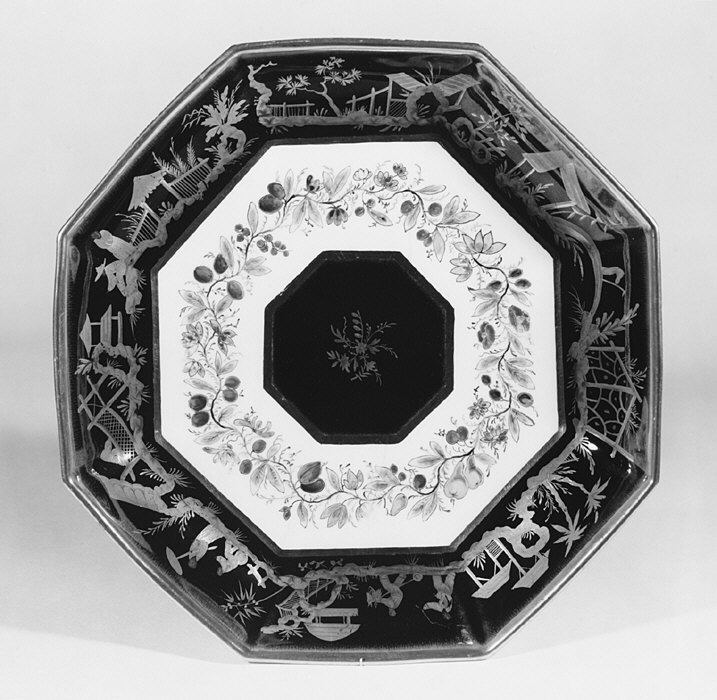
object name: dish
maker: sèvres manufactory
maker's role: manufactory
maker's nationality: french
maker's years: 1740-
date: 1804-1813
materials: hard paste porcelain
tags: human figures,flowers